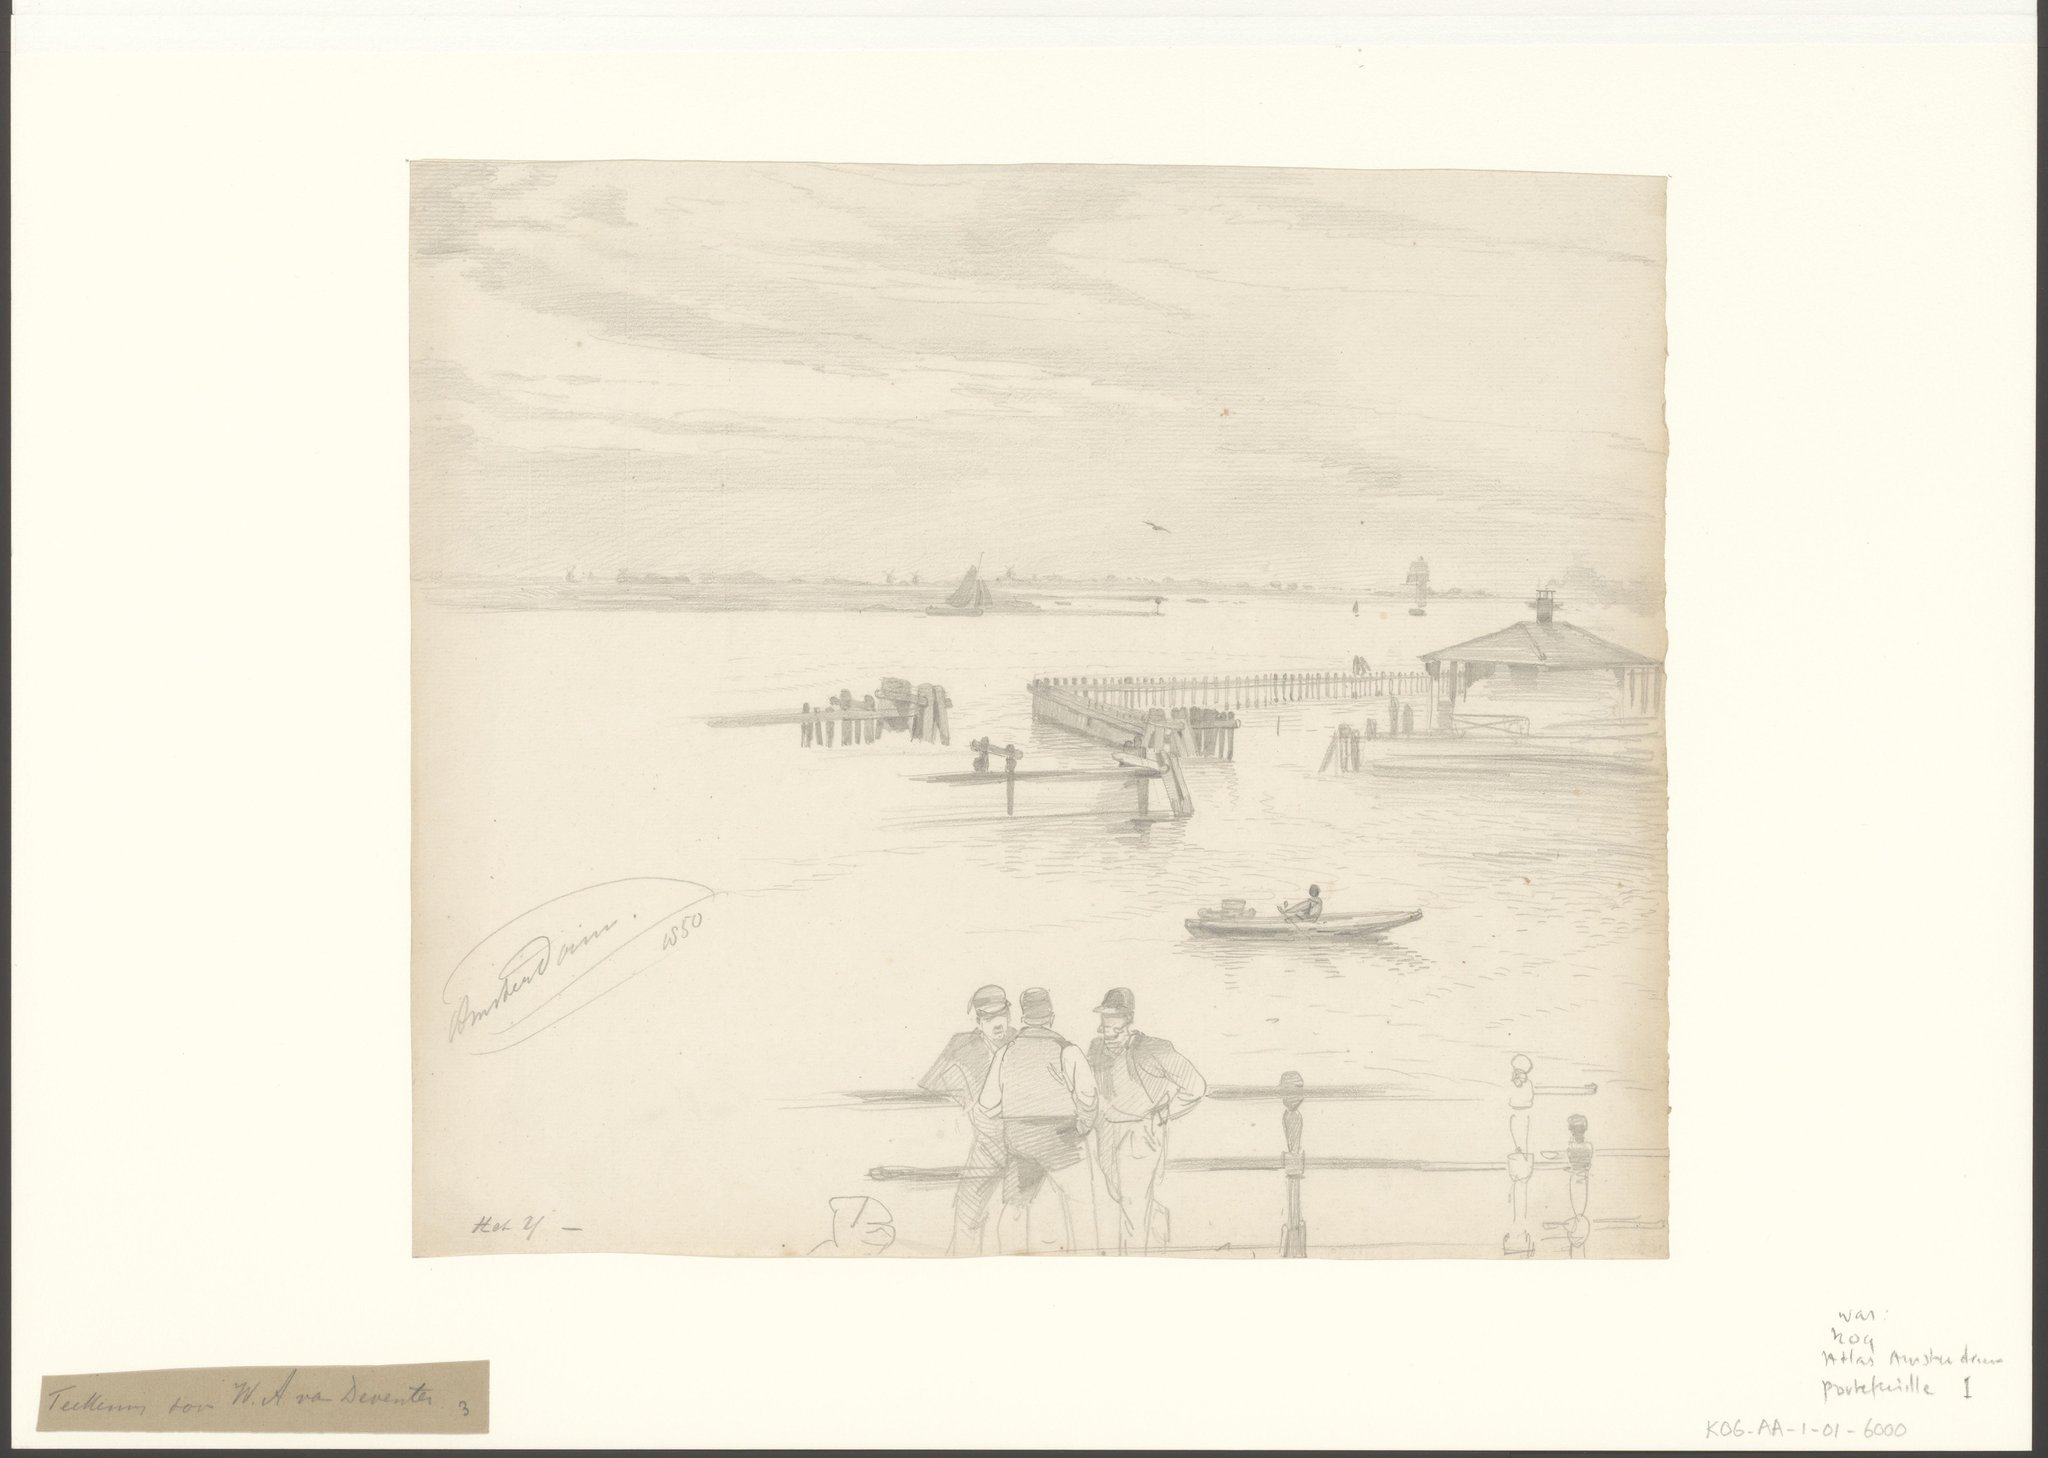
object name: drawing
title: Gezicht op het IJ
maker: willem anthonie van deventer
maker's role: draughtsman, painter, print maker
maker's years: 1824-1893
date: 1850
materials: paper, pencil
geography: amsterdam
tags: city-view in general; 'veduta', river, boat propelled by man or animal, amsterdam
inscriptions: inscription: ‘Amsterdam. / 1850 / Het Y-’, inscription: ‘Teekening van W.A. van Deventer 3’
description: Onderwerpsrubriek binnen de Atlas Amsterdam: Gezichten van de stad op het IJ.